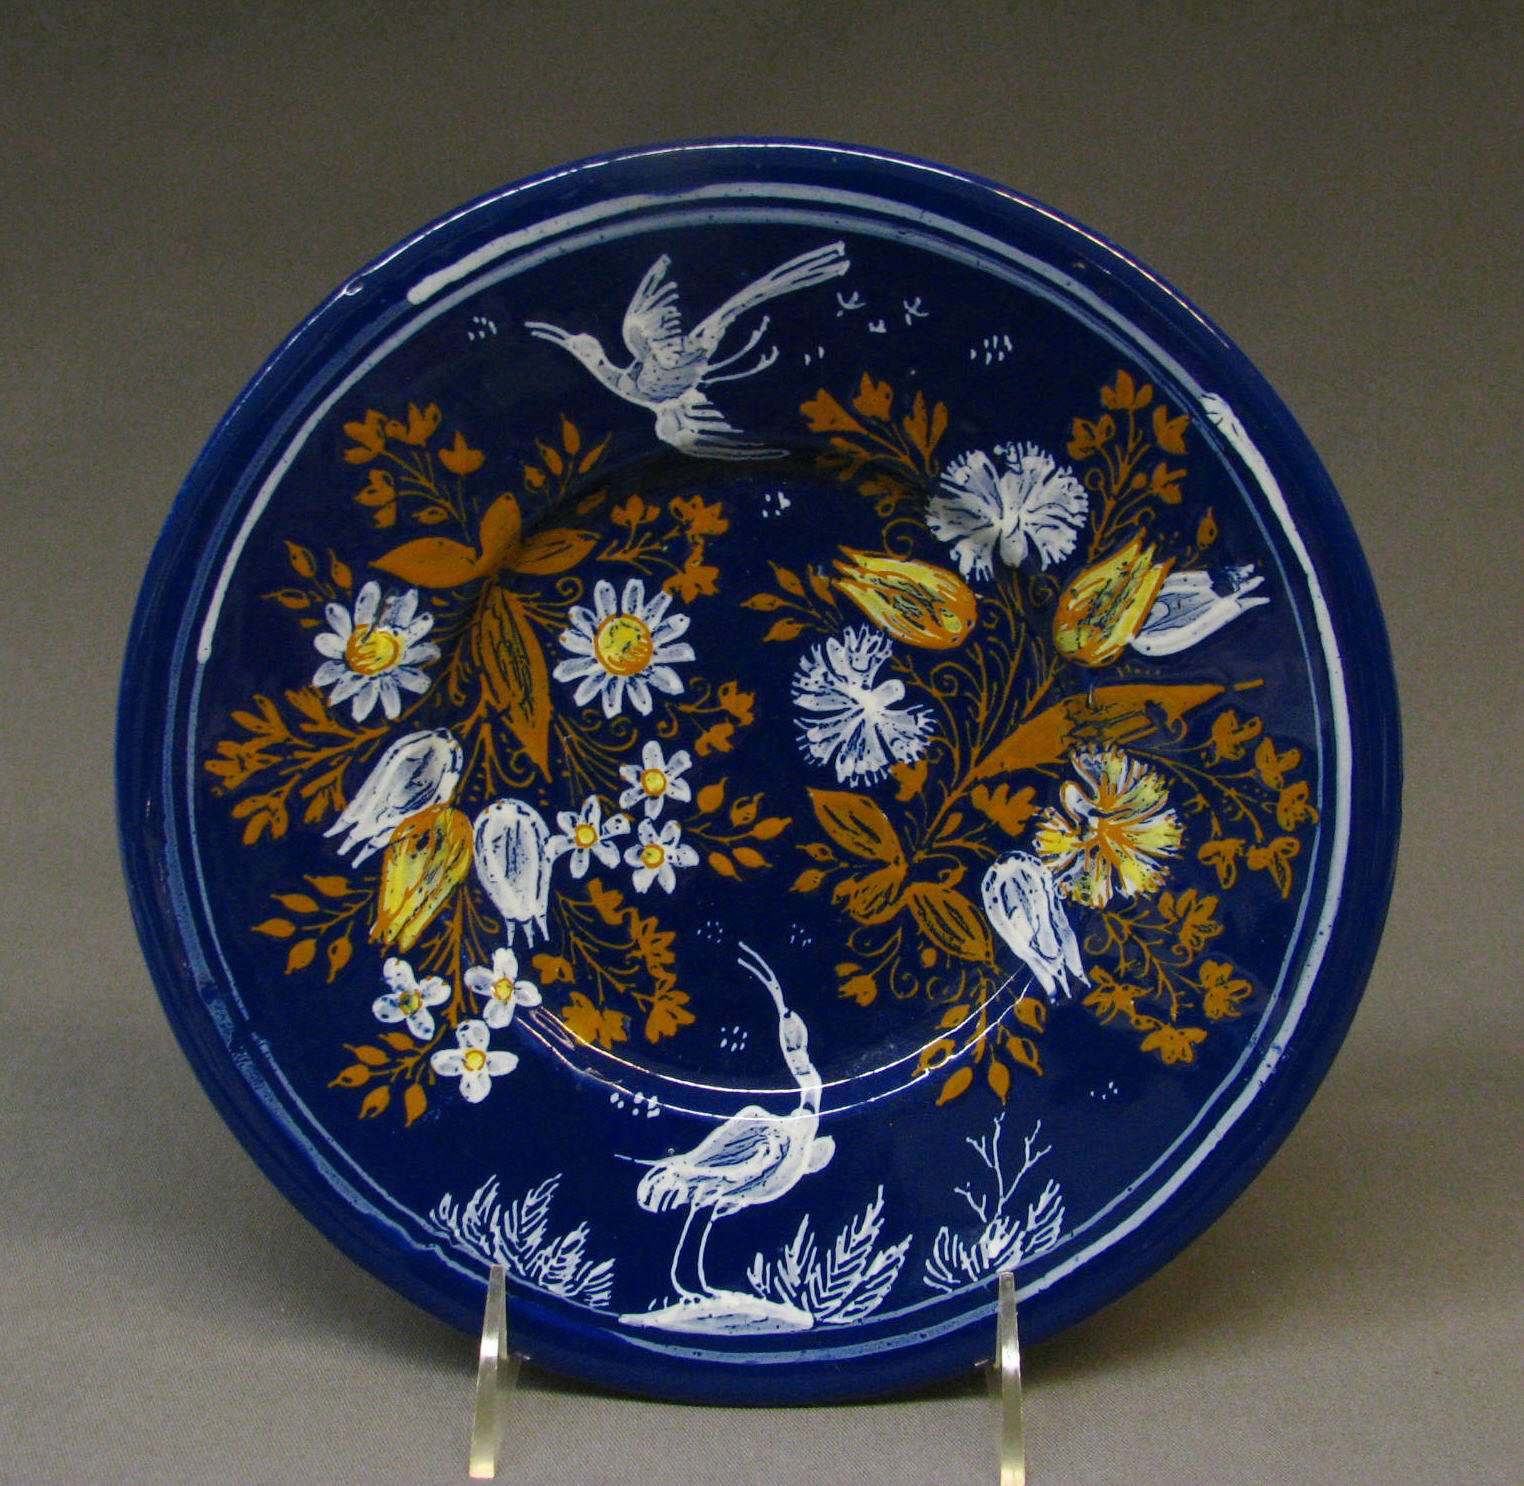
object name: plate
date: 1675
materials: faience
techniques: glazing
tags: birds,flowers